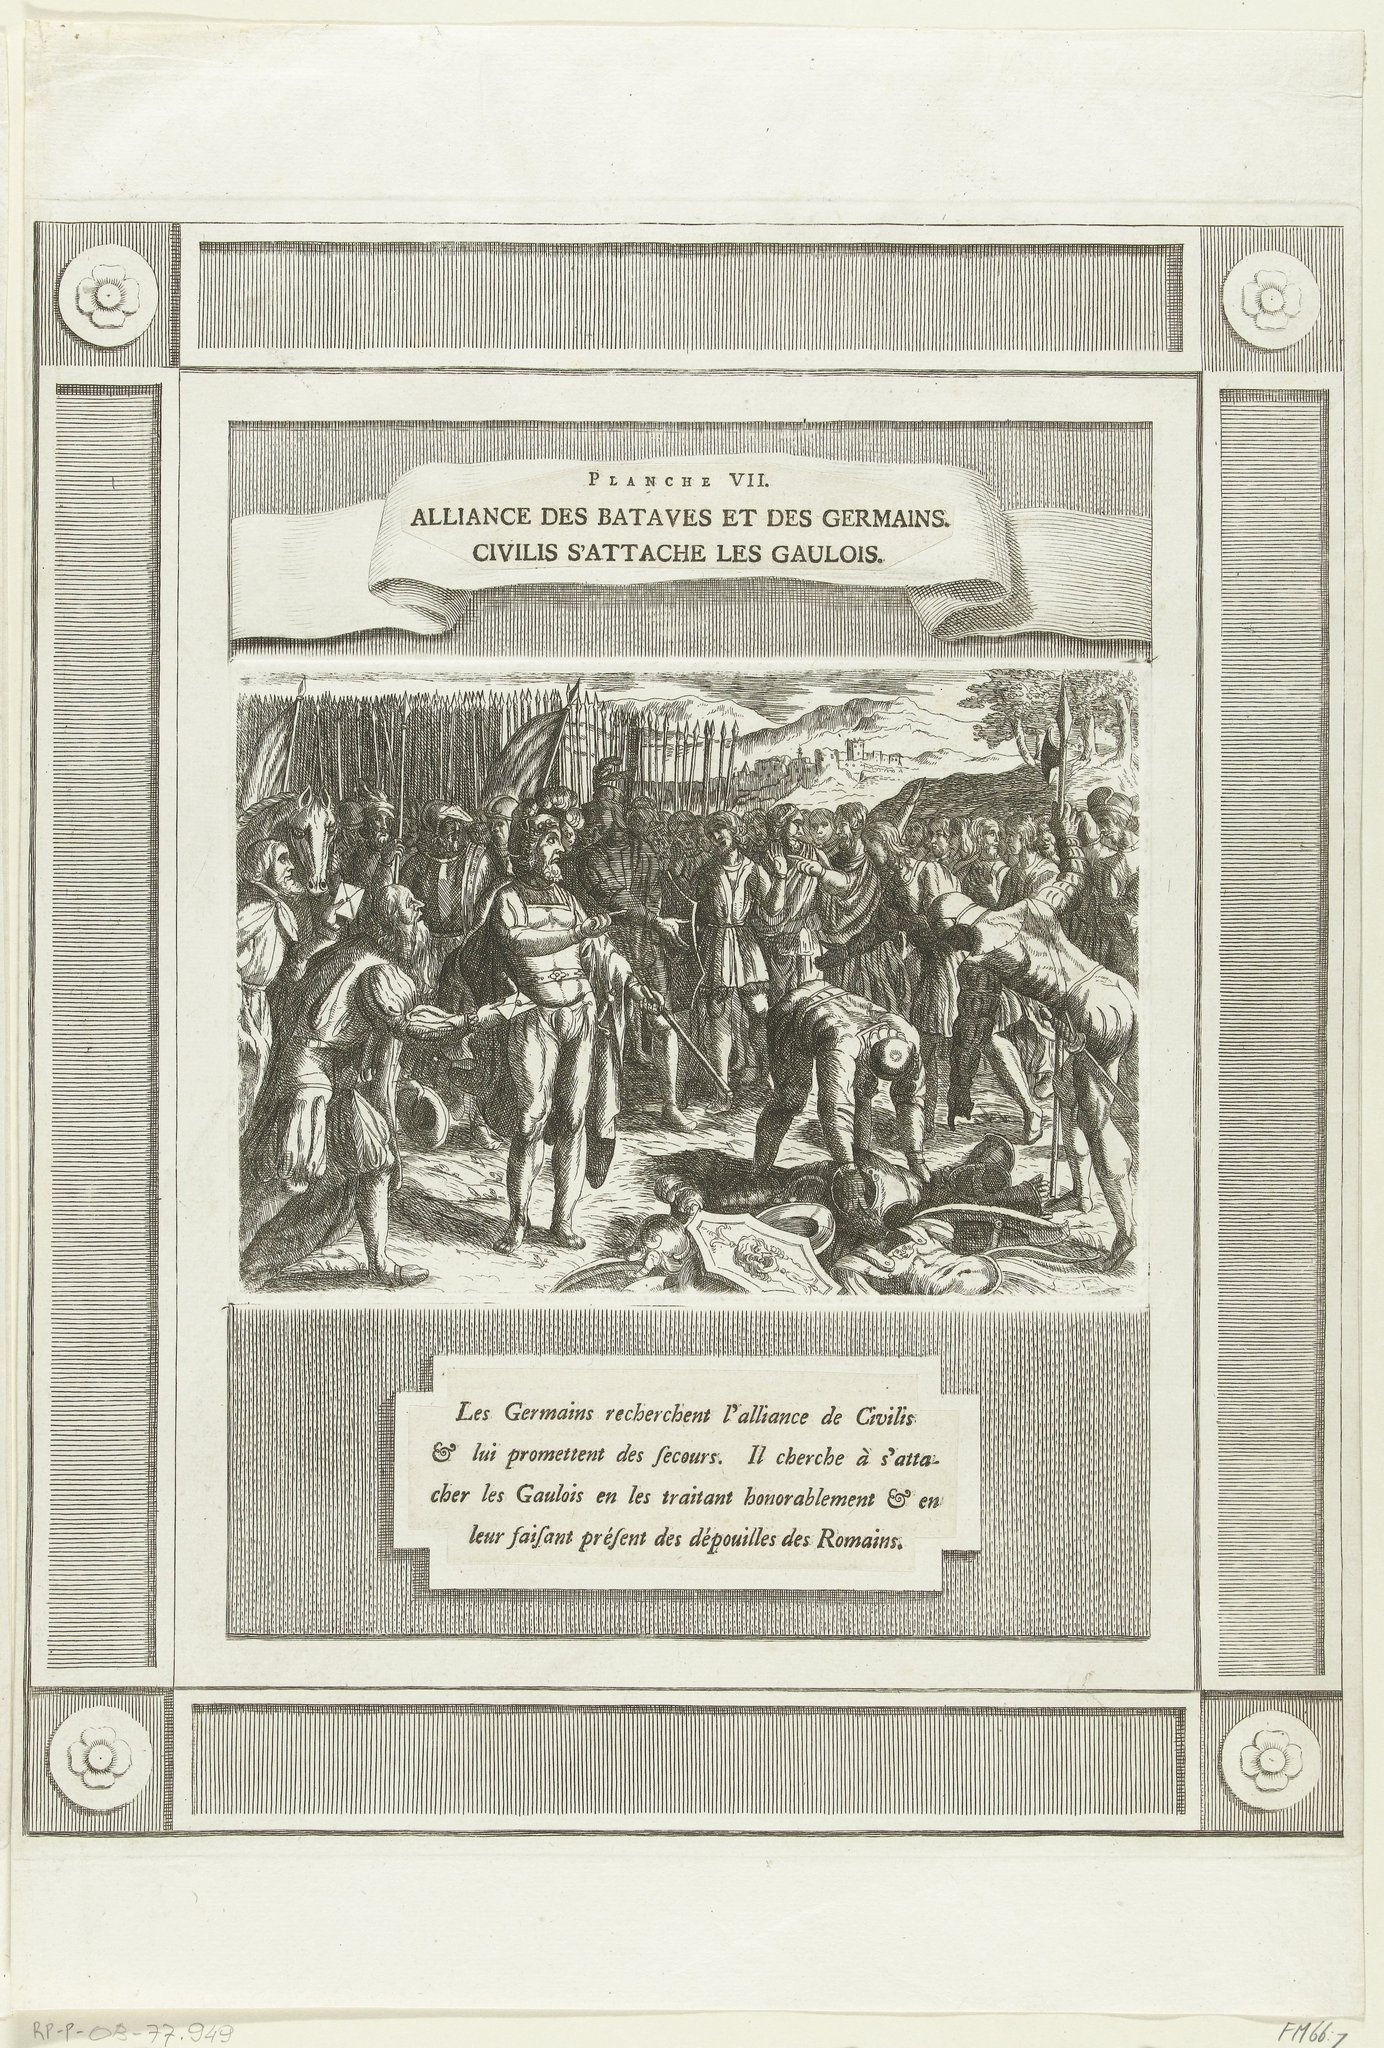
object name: history print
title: Alliance des Bataves et des Germains. Civilis s'attache les gaulois / planche VII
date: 1768-1770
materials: paper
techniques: engraving, etching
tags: extinct, 'historical' peoples (with name), netherlands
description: De Germaanse ambassadeur bezoekt Civilis en belooft steun. Prent 7 in een serie over de Bataafse Opstand, gekopieerd naar de reeks Batavorum cum Romanis bellum van Antonio Tempesta (Otto Vaenius, Antwerpen 1612). Illustratie voor: Marquis de St. Simon, Histoire de la guerre des Bataves et des Romains, d'après César; Corneille Tacite, Aux dépens de Marc-Michel Rey, Amsterdam 1770. Voorstellingen gedrukt in een grote ornamentele omlijsting waarin bovenaan een uitgeknipte titel en onderaan een onderschrift in het Frans is geplakt.